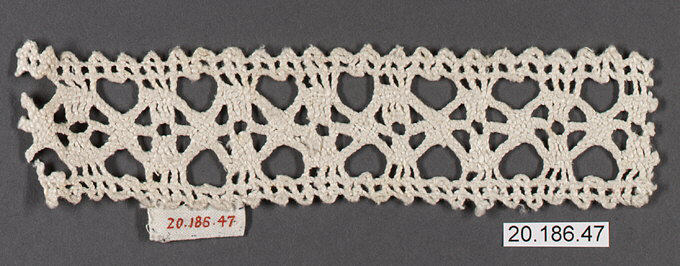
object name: insertion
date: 1501-1600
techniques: lace